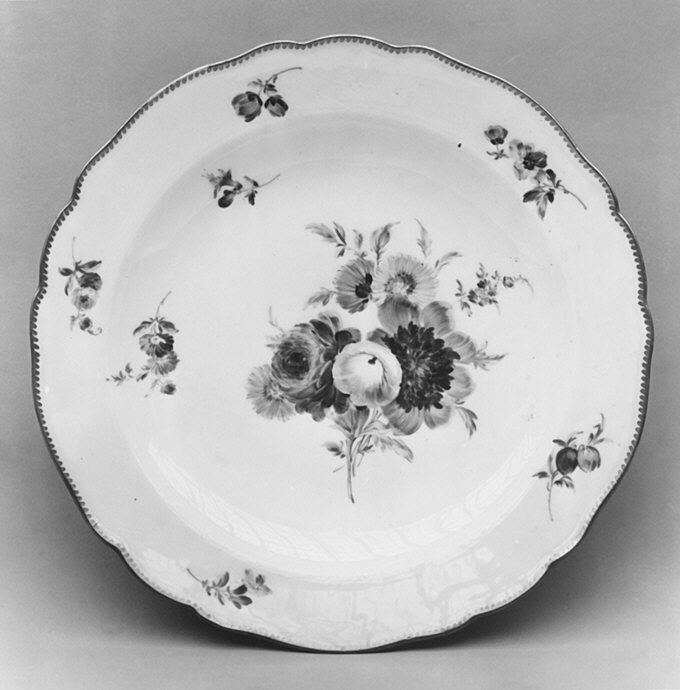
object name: plate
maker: meissen manufactory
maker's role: manufactory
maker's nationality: german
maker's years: 1710-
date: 1770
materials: hard paste porcelain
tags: flowers